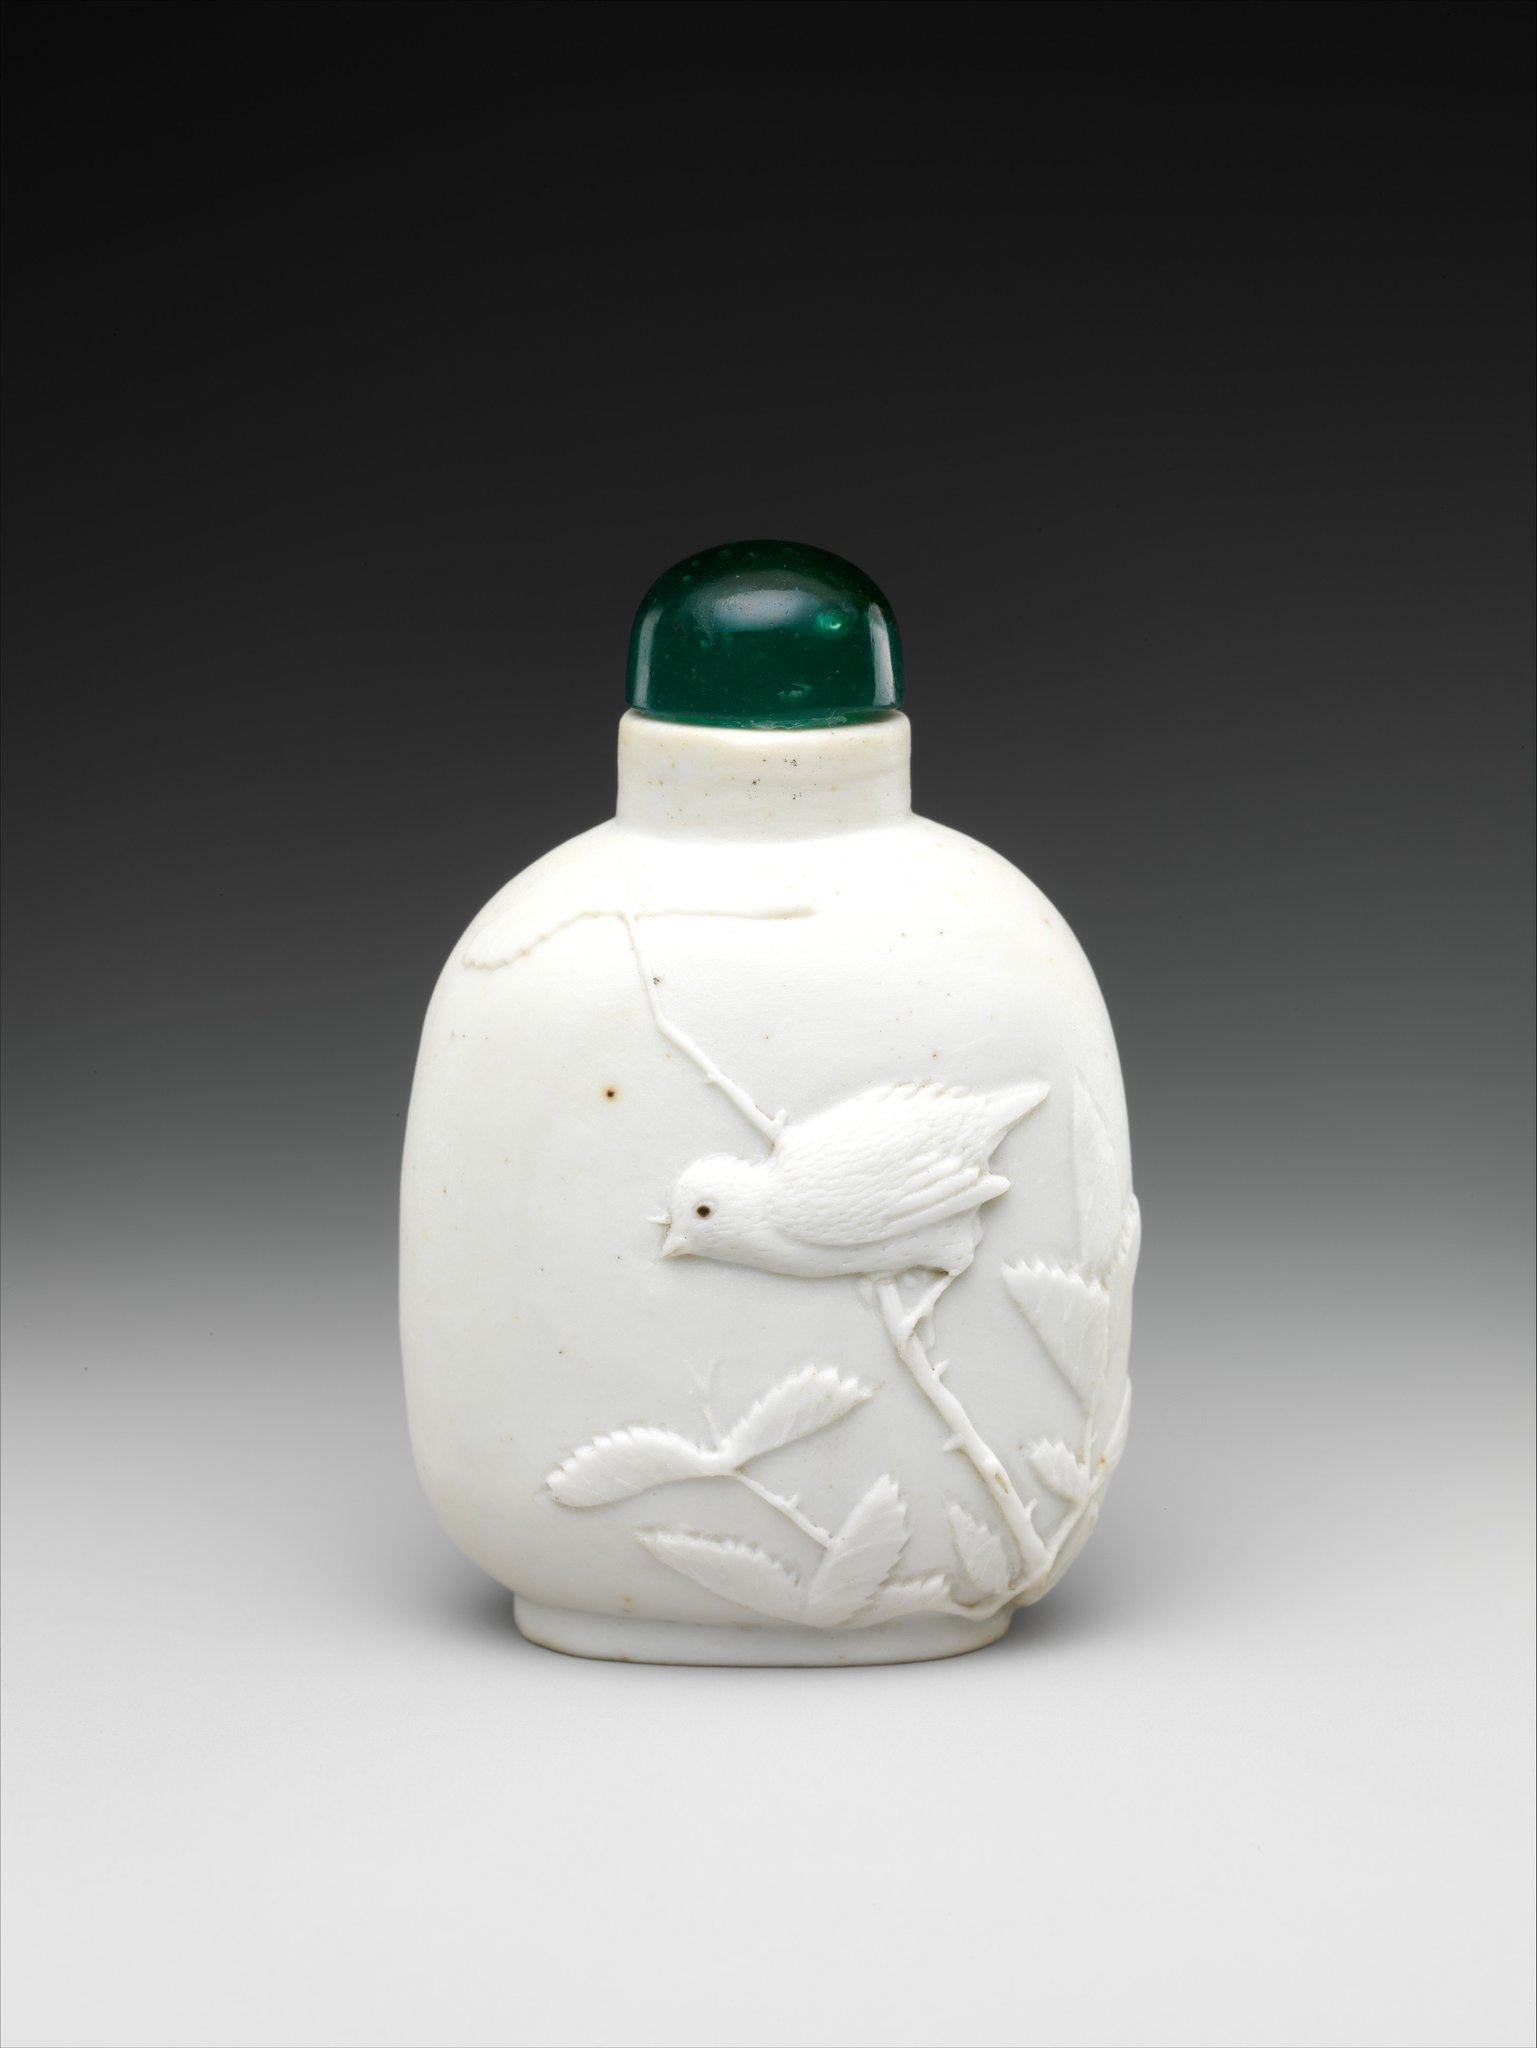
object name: snuff bottle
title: Snuff bottle with bird on a branch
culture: chinese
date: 1801-1900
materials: glass, porcelain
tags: birds